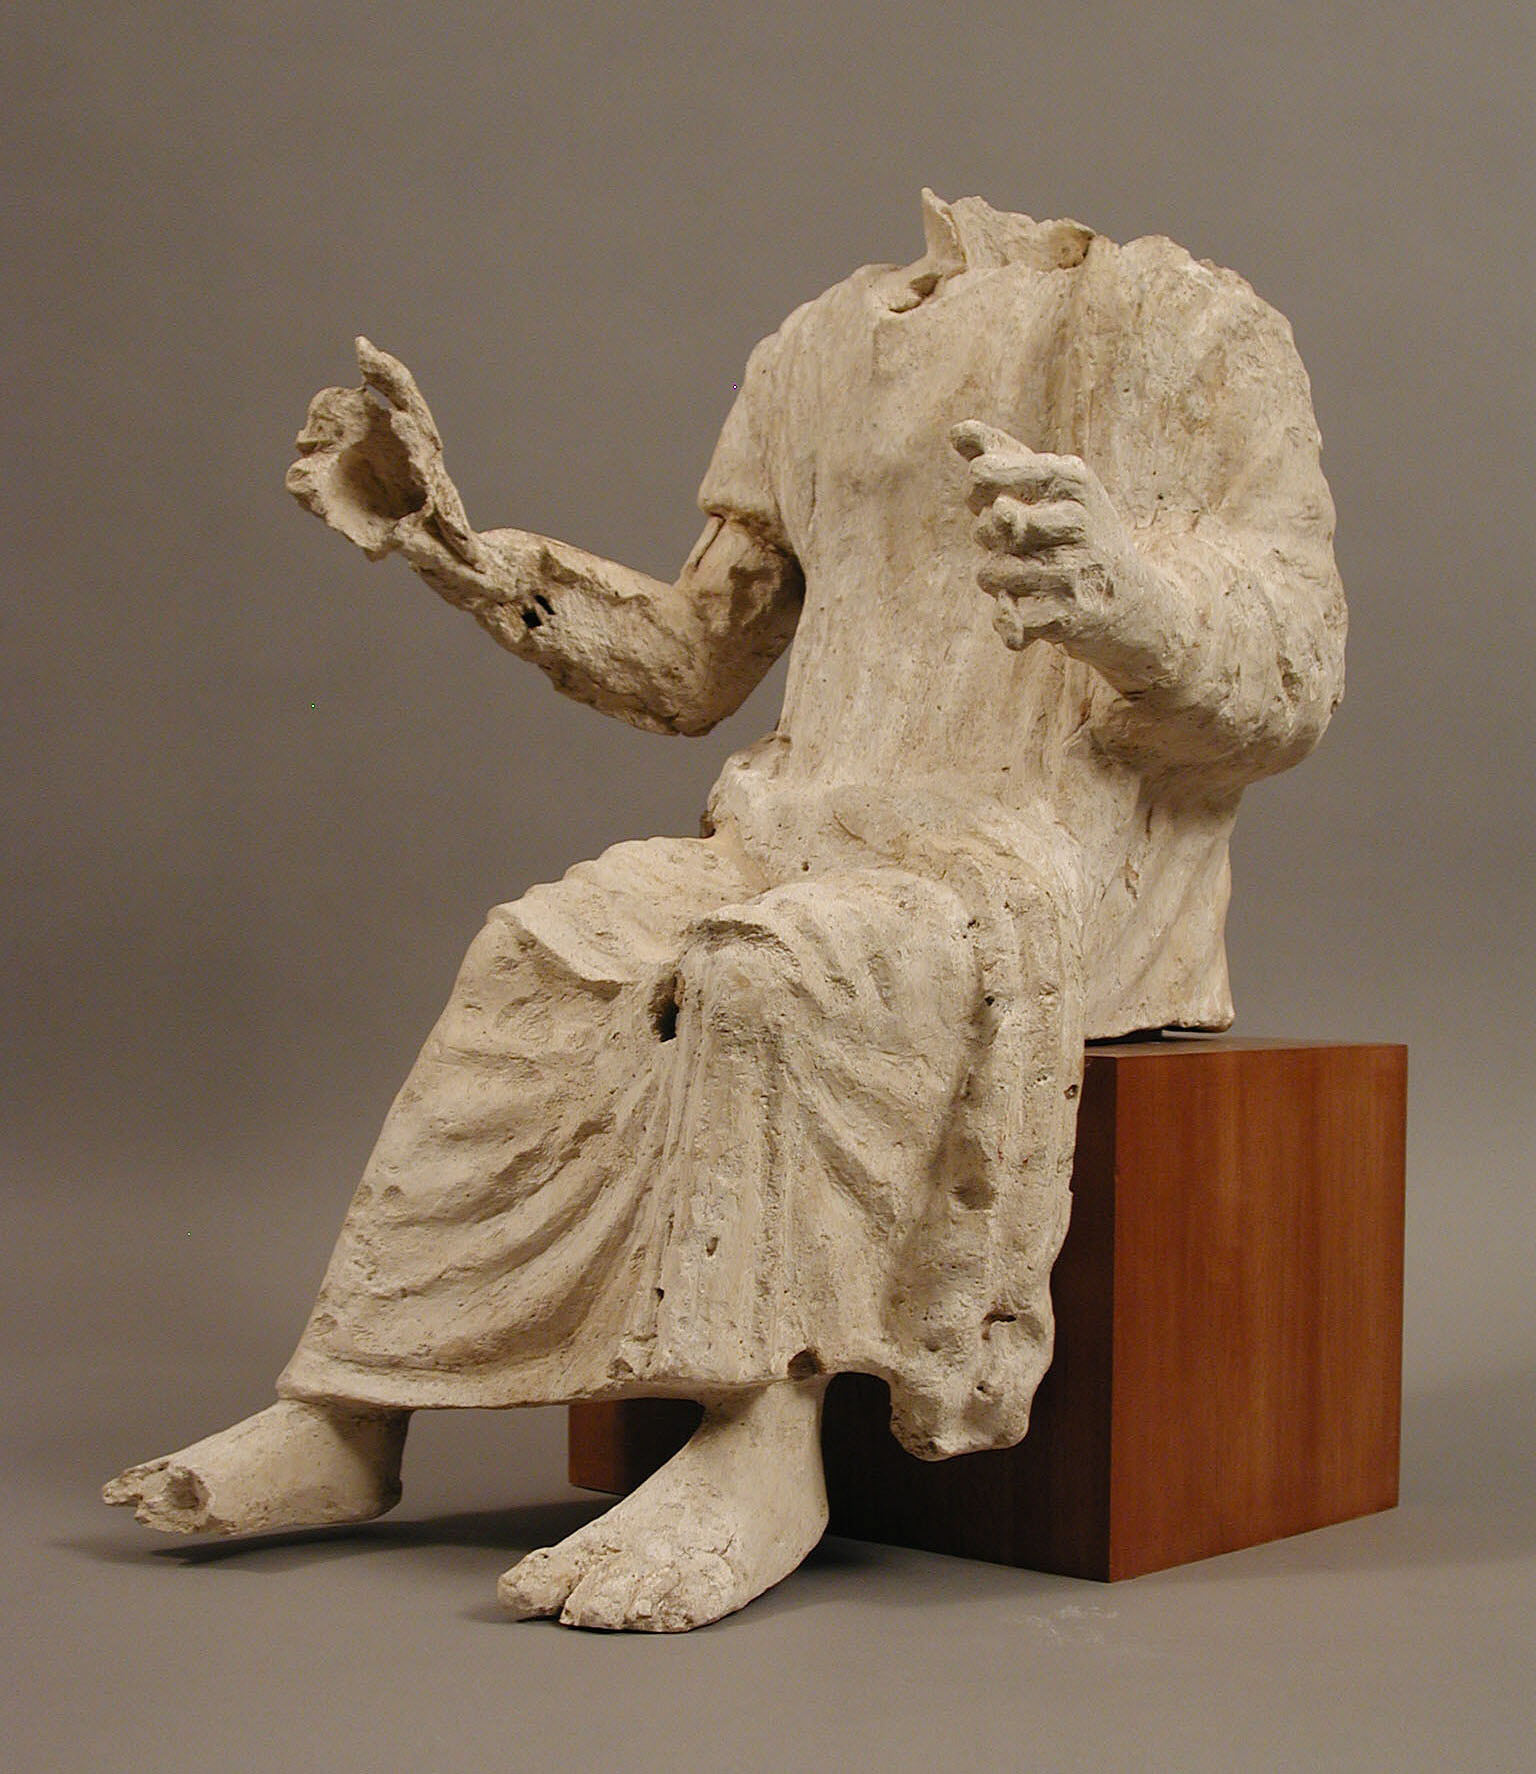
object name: statuette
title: Seated Man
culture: coptic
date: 301-700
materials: plaster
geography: egypt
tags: men